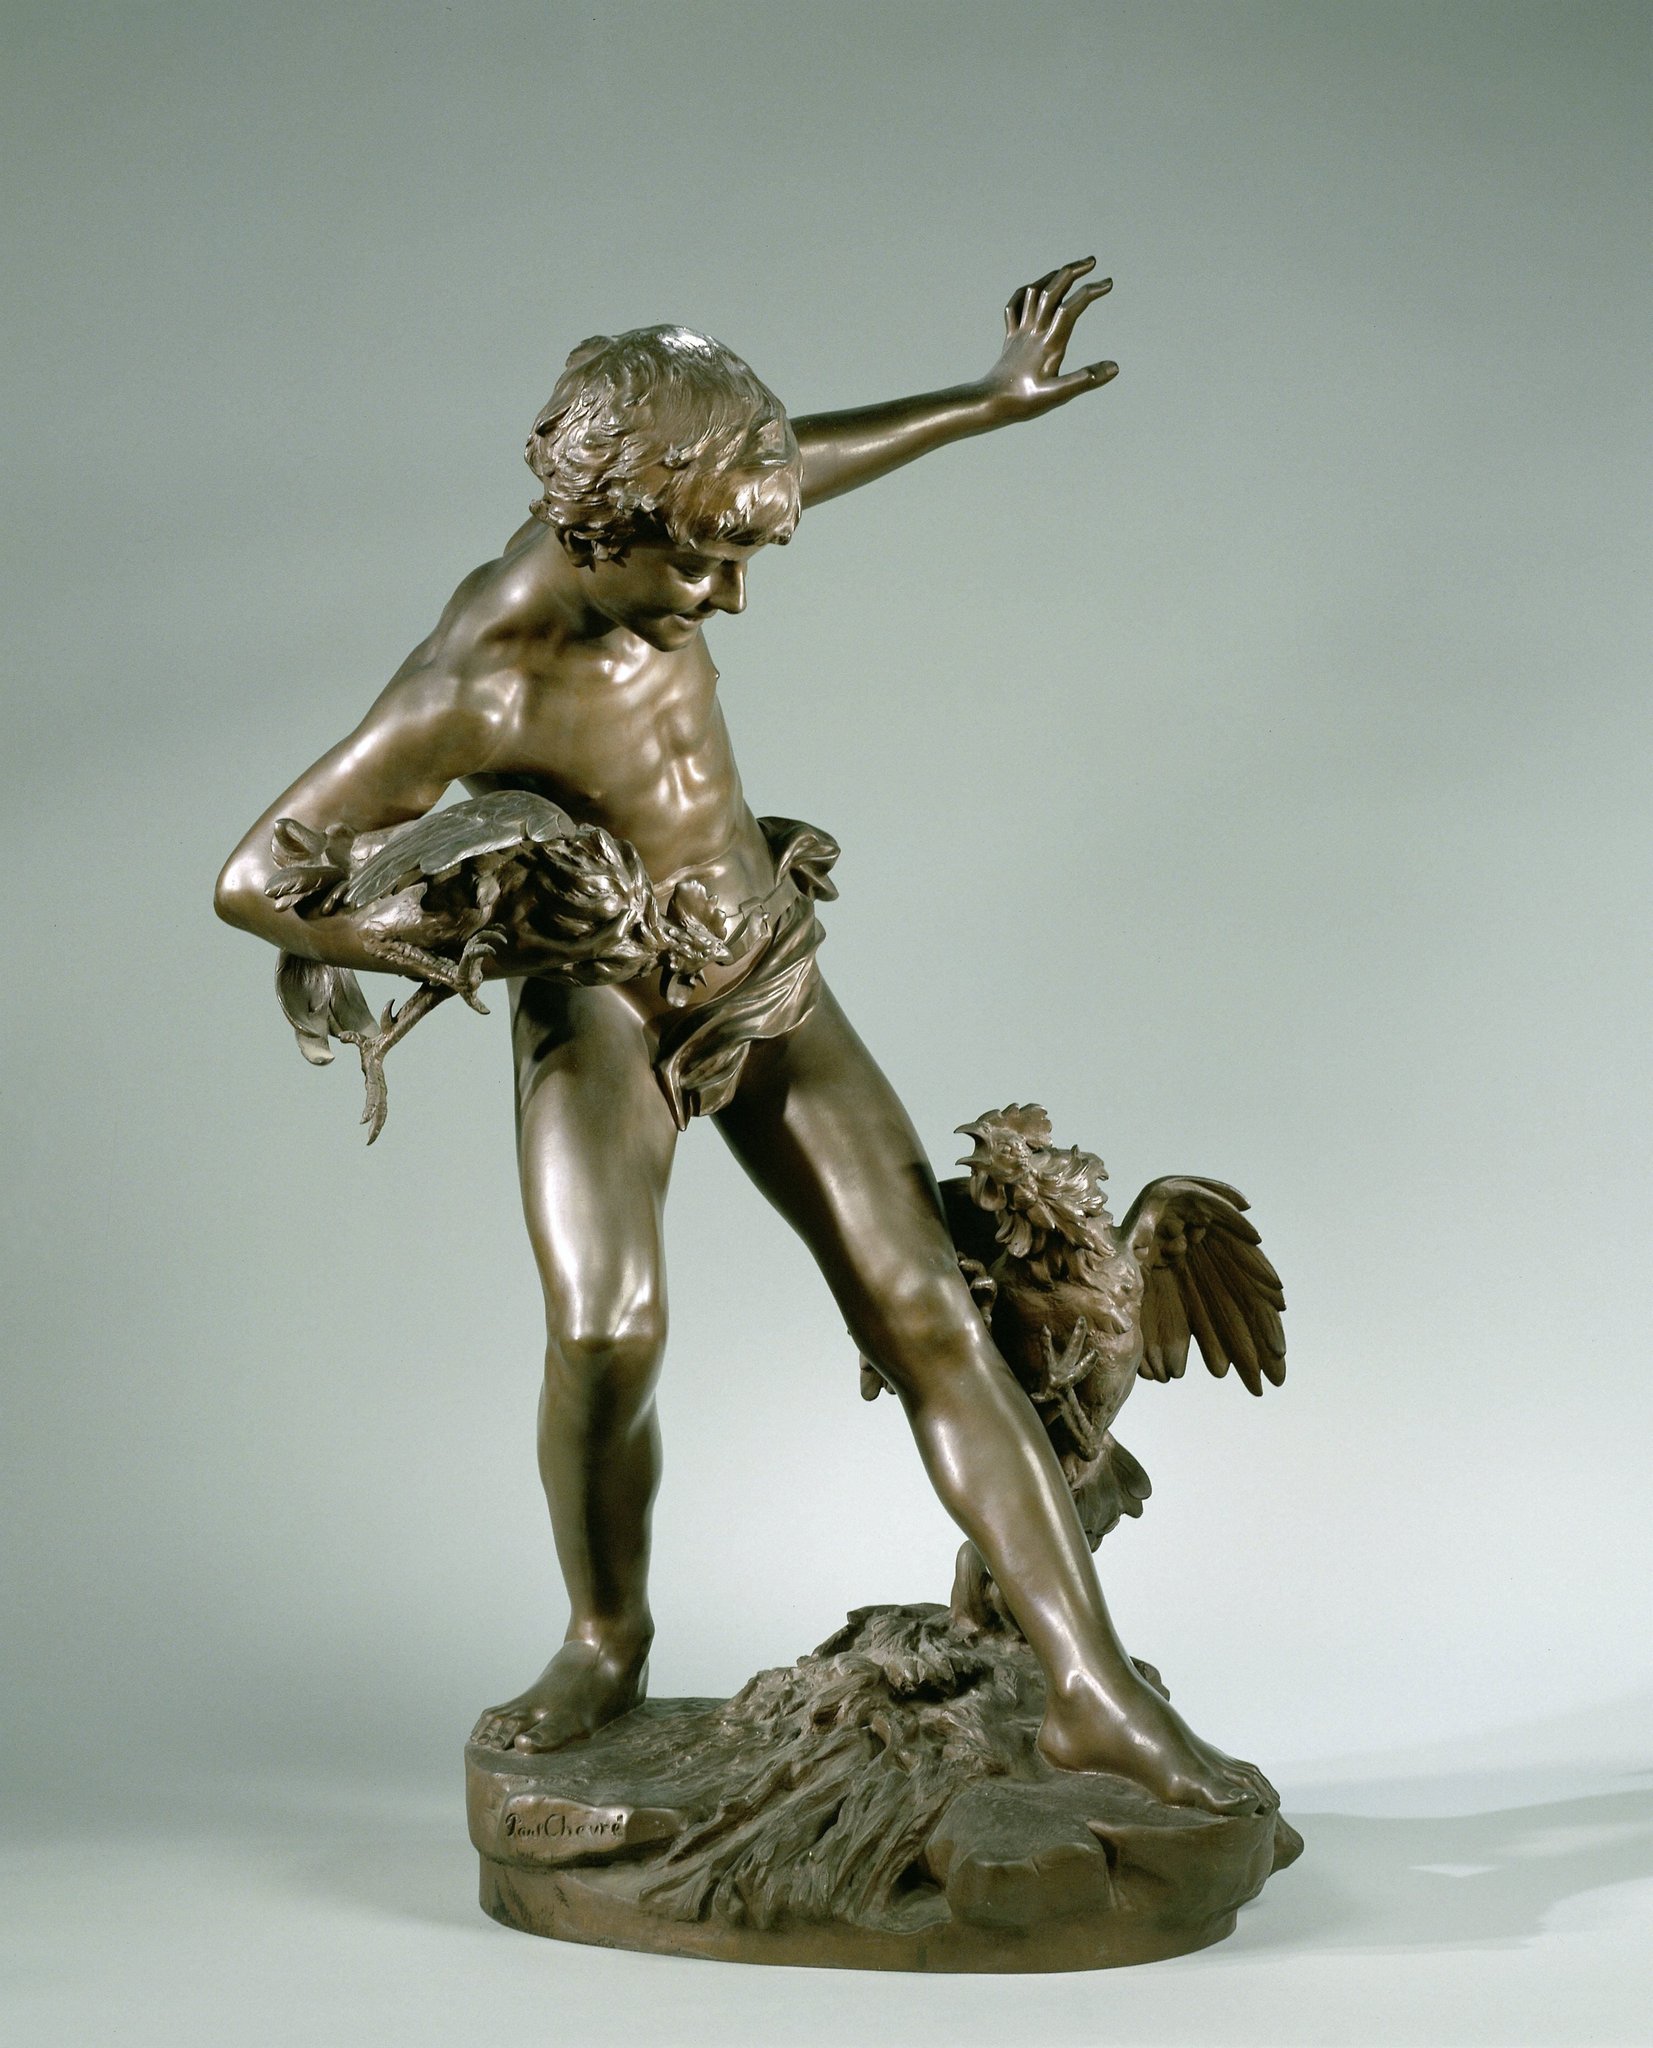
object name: sculpture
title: Knaap met twee vechtende hanen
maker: paul romain chevré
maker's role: sculptor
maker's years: 1867-1914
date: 1850-1950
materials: bronze